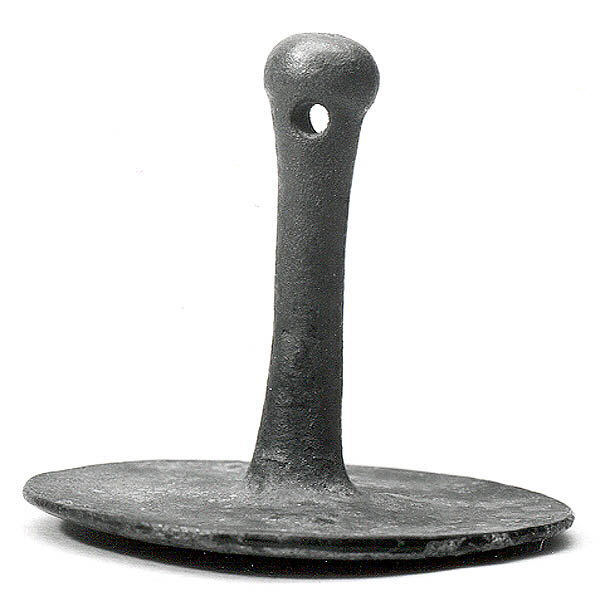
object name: cymbal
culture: hattian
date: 2300-2000 BCE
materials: bronze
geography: central anatolia